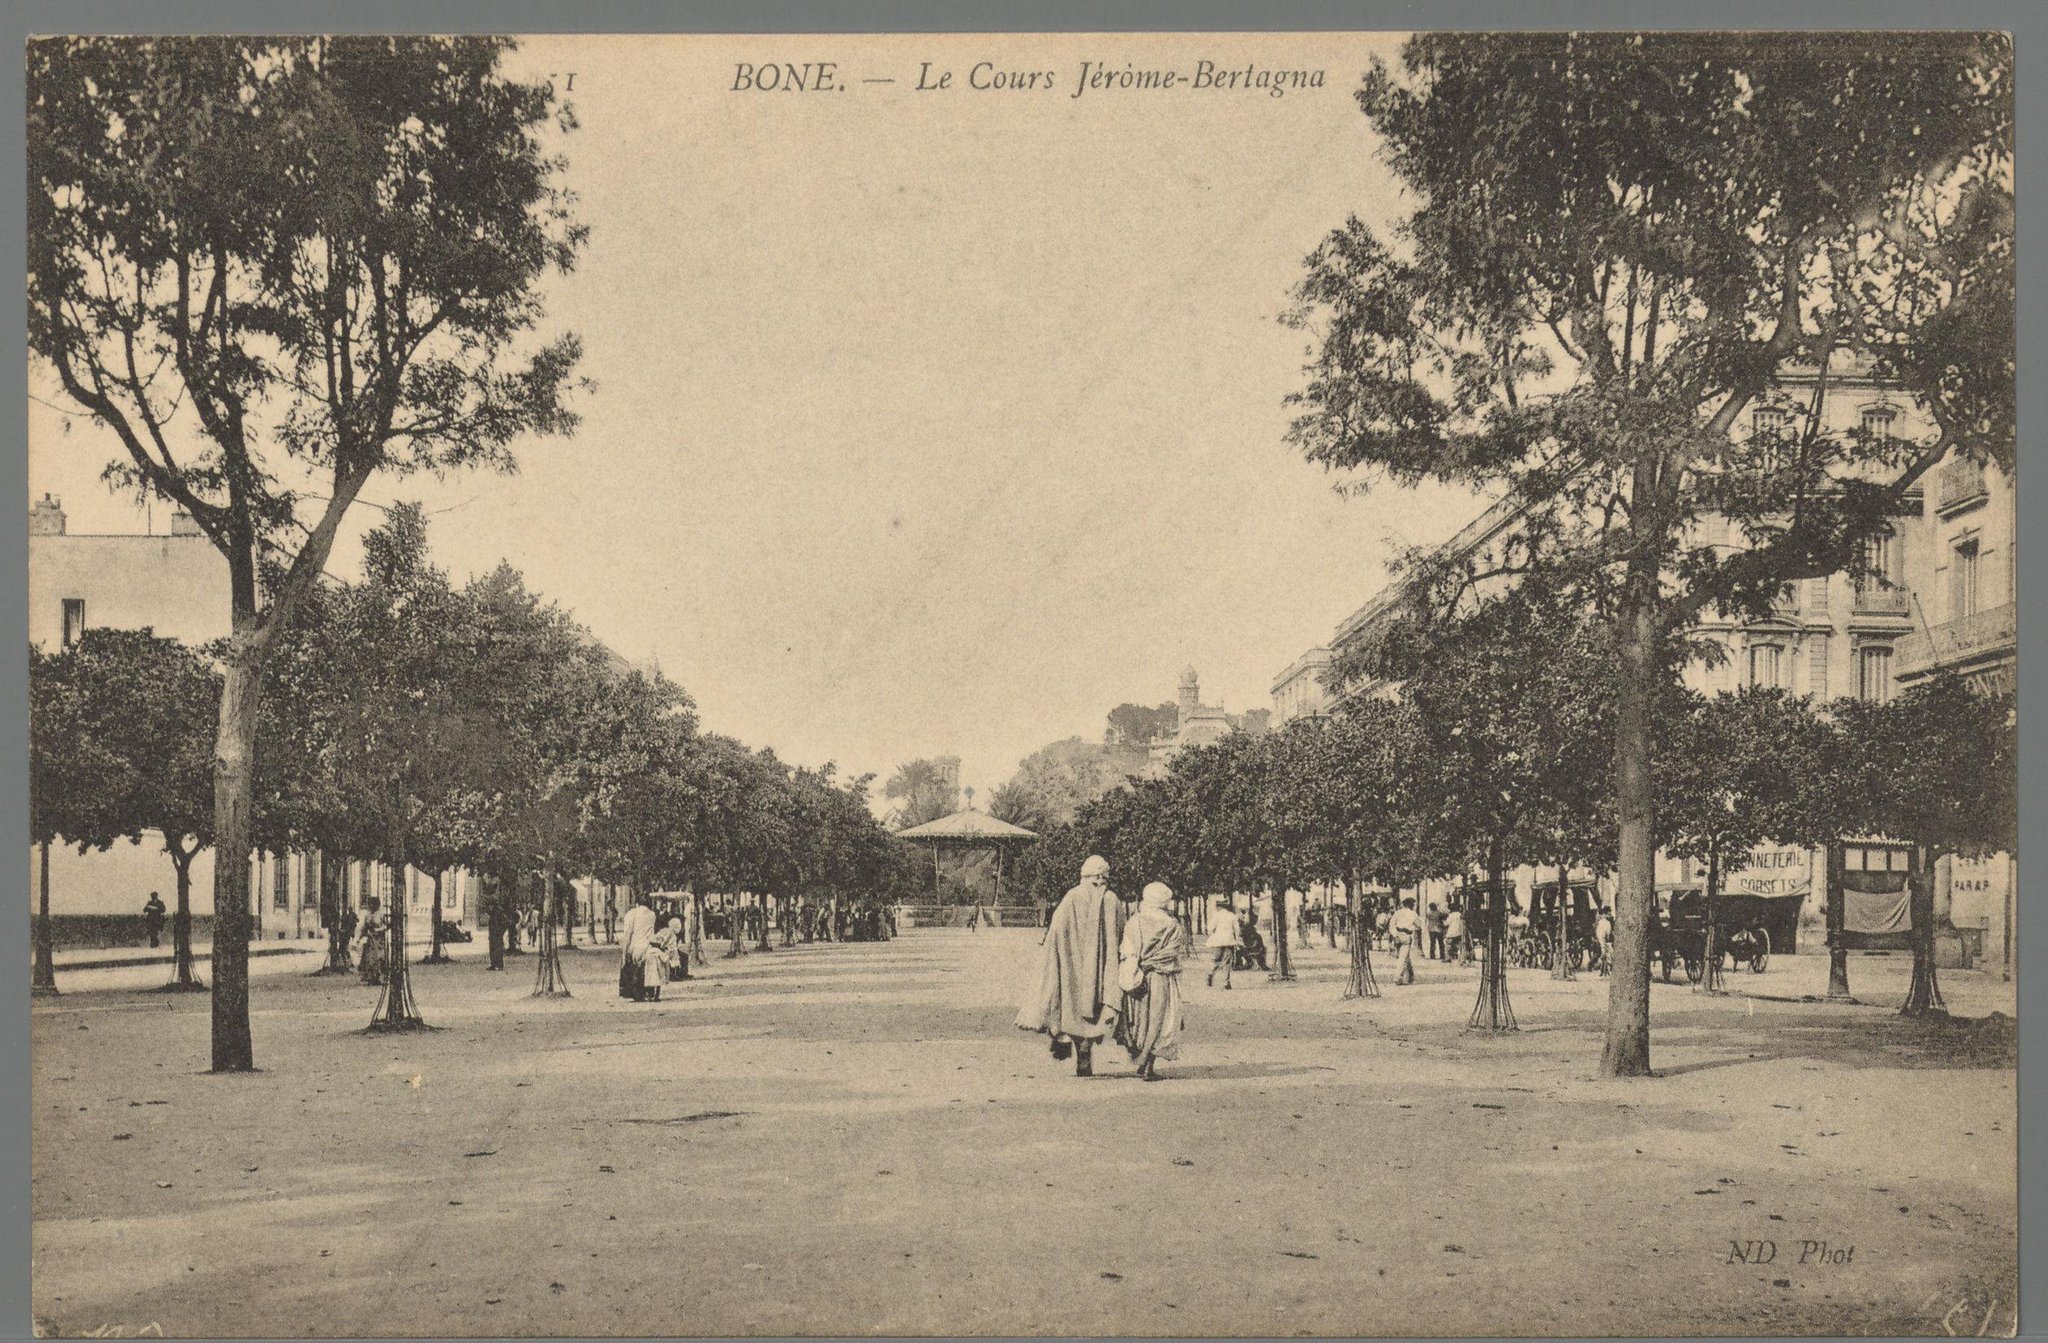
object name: photomechanical print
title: Bone. Le Cours Jérôme-Berlagna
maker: Anonymous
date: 1903-1905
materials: cardboard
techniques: photograph, writing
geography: bône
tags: square, place, circus, etc. (+ city(-scape) with figures, staffage)